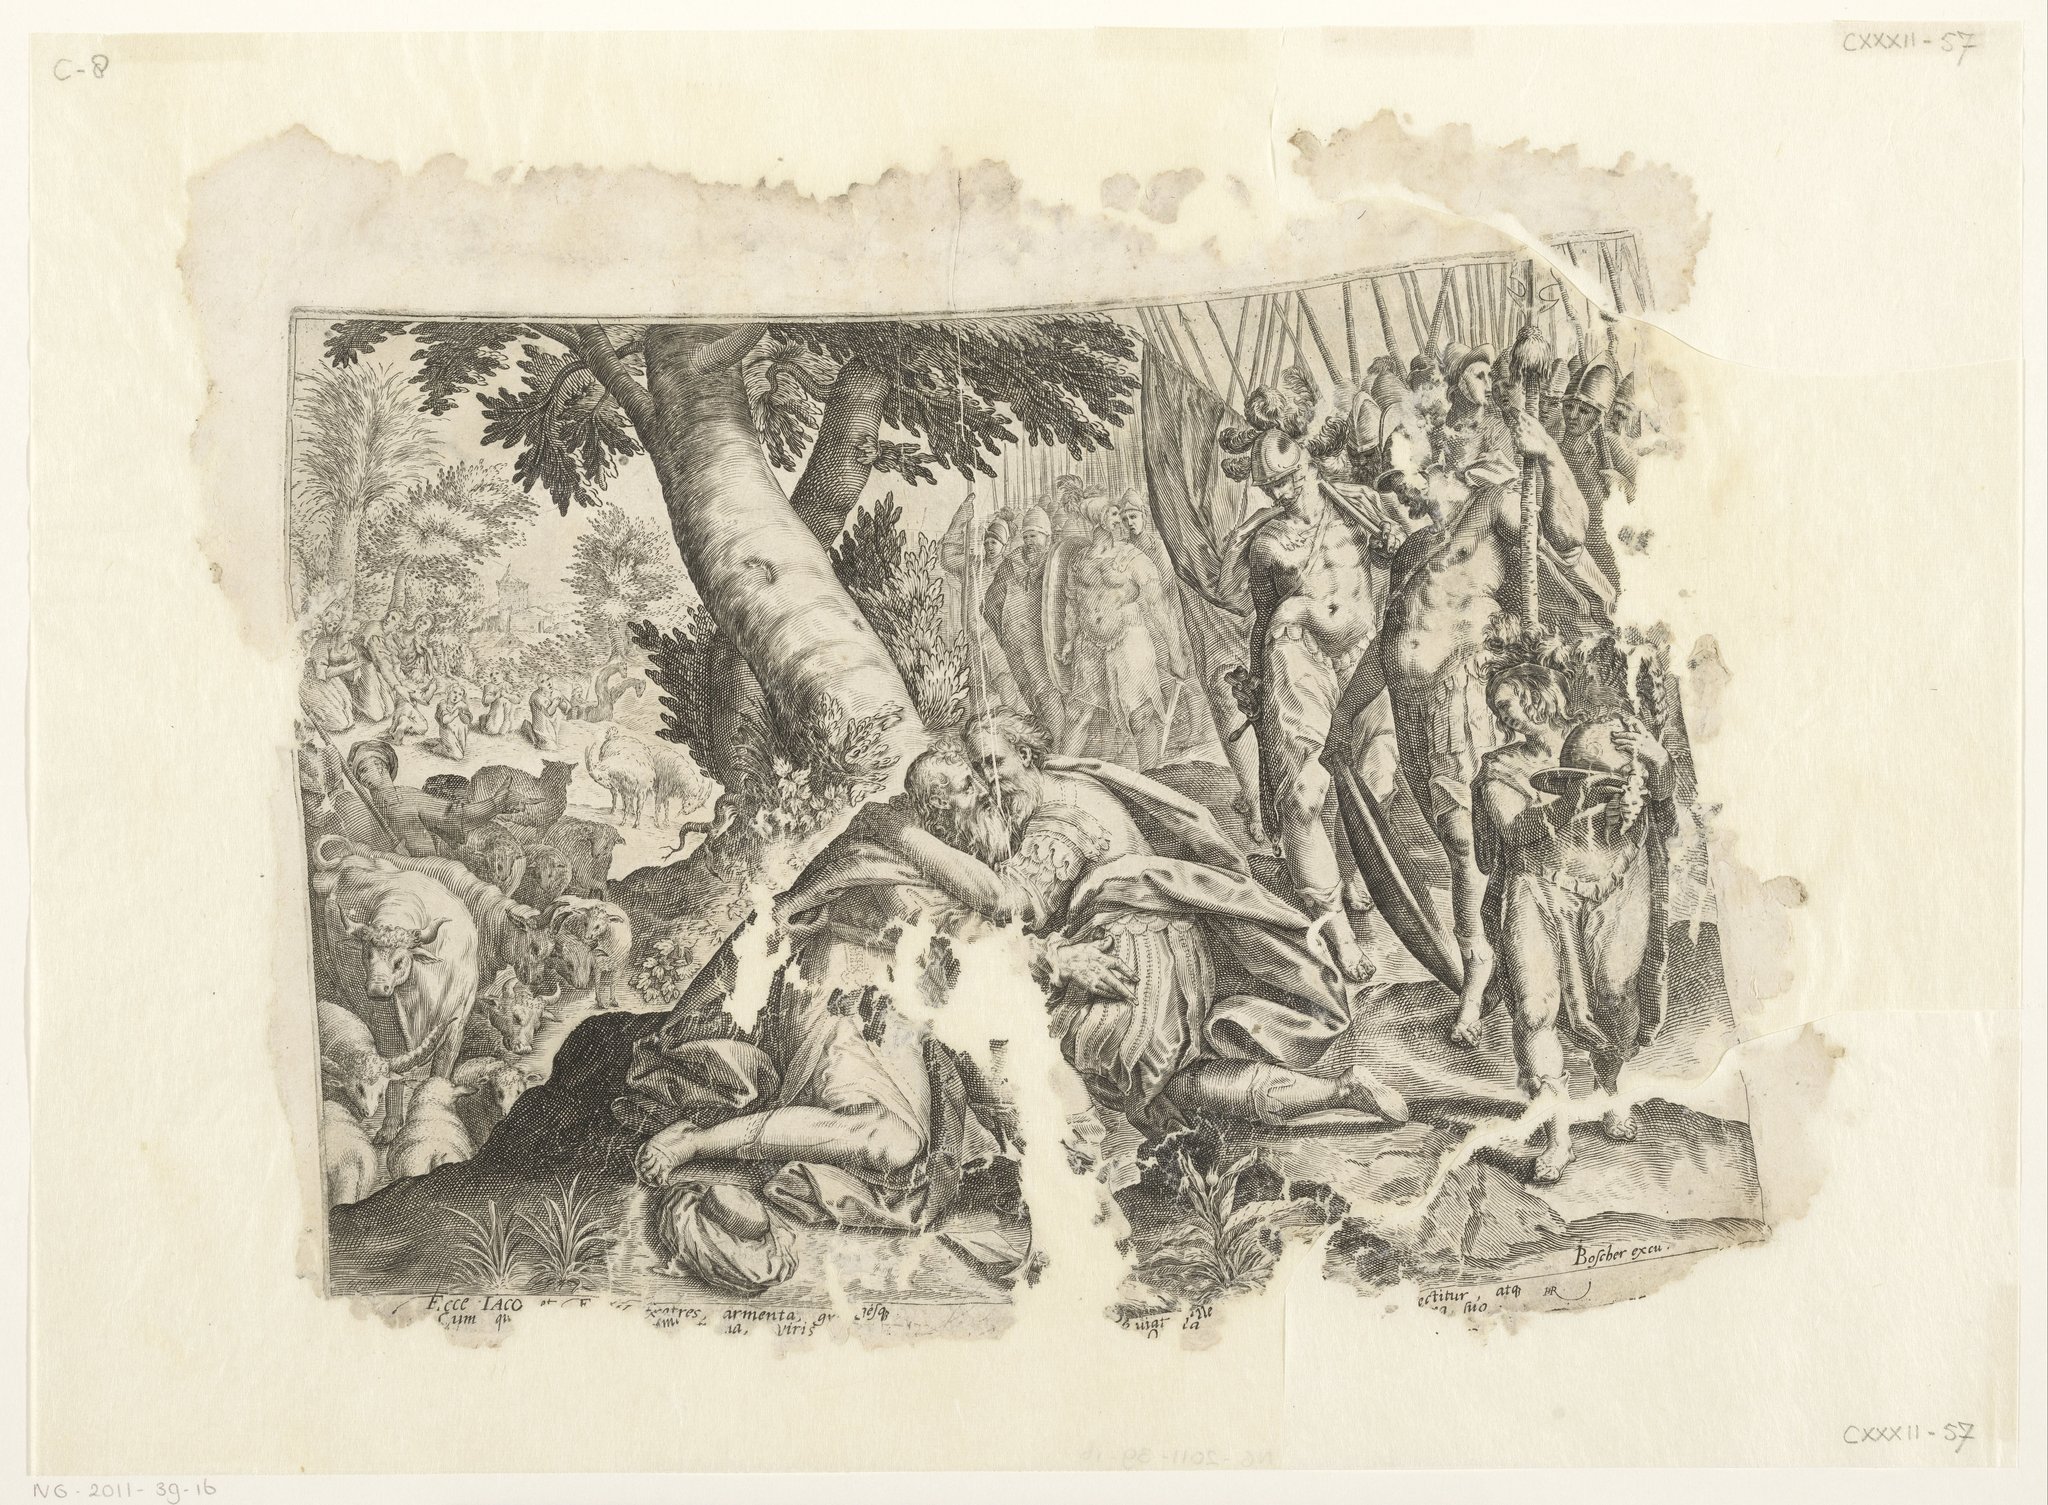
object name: print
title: Verzoening van Jakob en Esau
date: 1580-1596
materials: paper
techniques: engraving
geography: northern netherlands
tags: the meeting between esau and jacob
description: Tot dusverre was deze prent alleen bekend in een latere editie met het adres van C.J. Visscher in het door hem uitgegeven Theatrum Biblicum uit 1643, zie RP-P-1976-30-39. De prenten in de Nova Zembla collectie zijn tijdens een expeditie van Willem Barendsz en Jacob van Heemskerk in 1596-1597 noodgedwongen in het winterkamp, het ‘Behouden Huis’, op het eiland achtergelaten. De prenten waren in één of meerdere stapels als handelswaar meegenomen vanuit Amsterdam. Bijna drie eeuwen later, in 1871, keerde de Noor Elling Carlsen terug naar Nova Zembla en vond daar de restanten van het ‘Behouden Huis, inclusief een groot deel van de inventaris. Een deel van de prenten, in de vorm van aaneengekoekte kluiten, werd toen ook teruggevonden. De papierkluiten waren soms op meerdere plekken gebroken. Tussen 1975-1979 zijn de prenten van elkaar gescheiden. Dit leverde in totaal ca. 1000 fragmenten van ca. 400 afdrukken van ca. 150 verschillende prenten op. Voor zover mogelijk zijn de fragmenten samengevoegd en zijn de prenten gereconstrueerd.